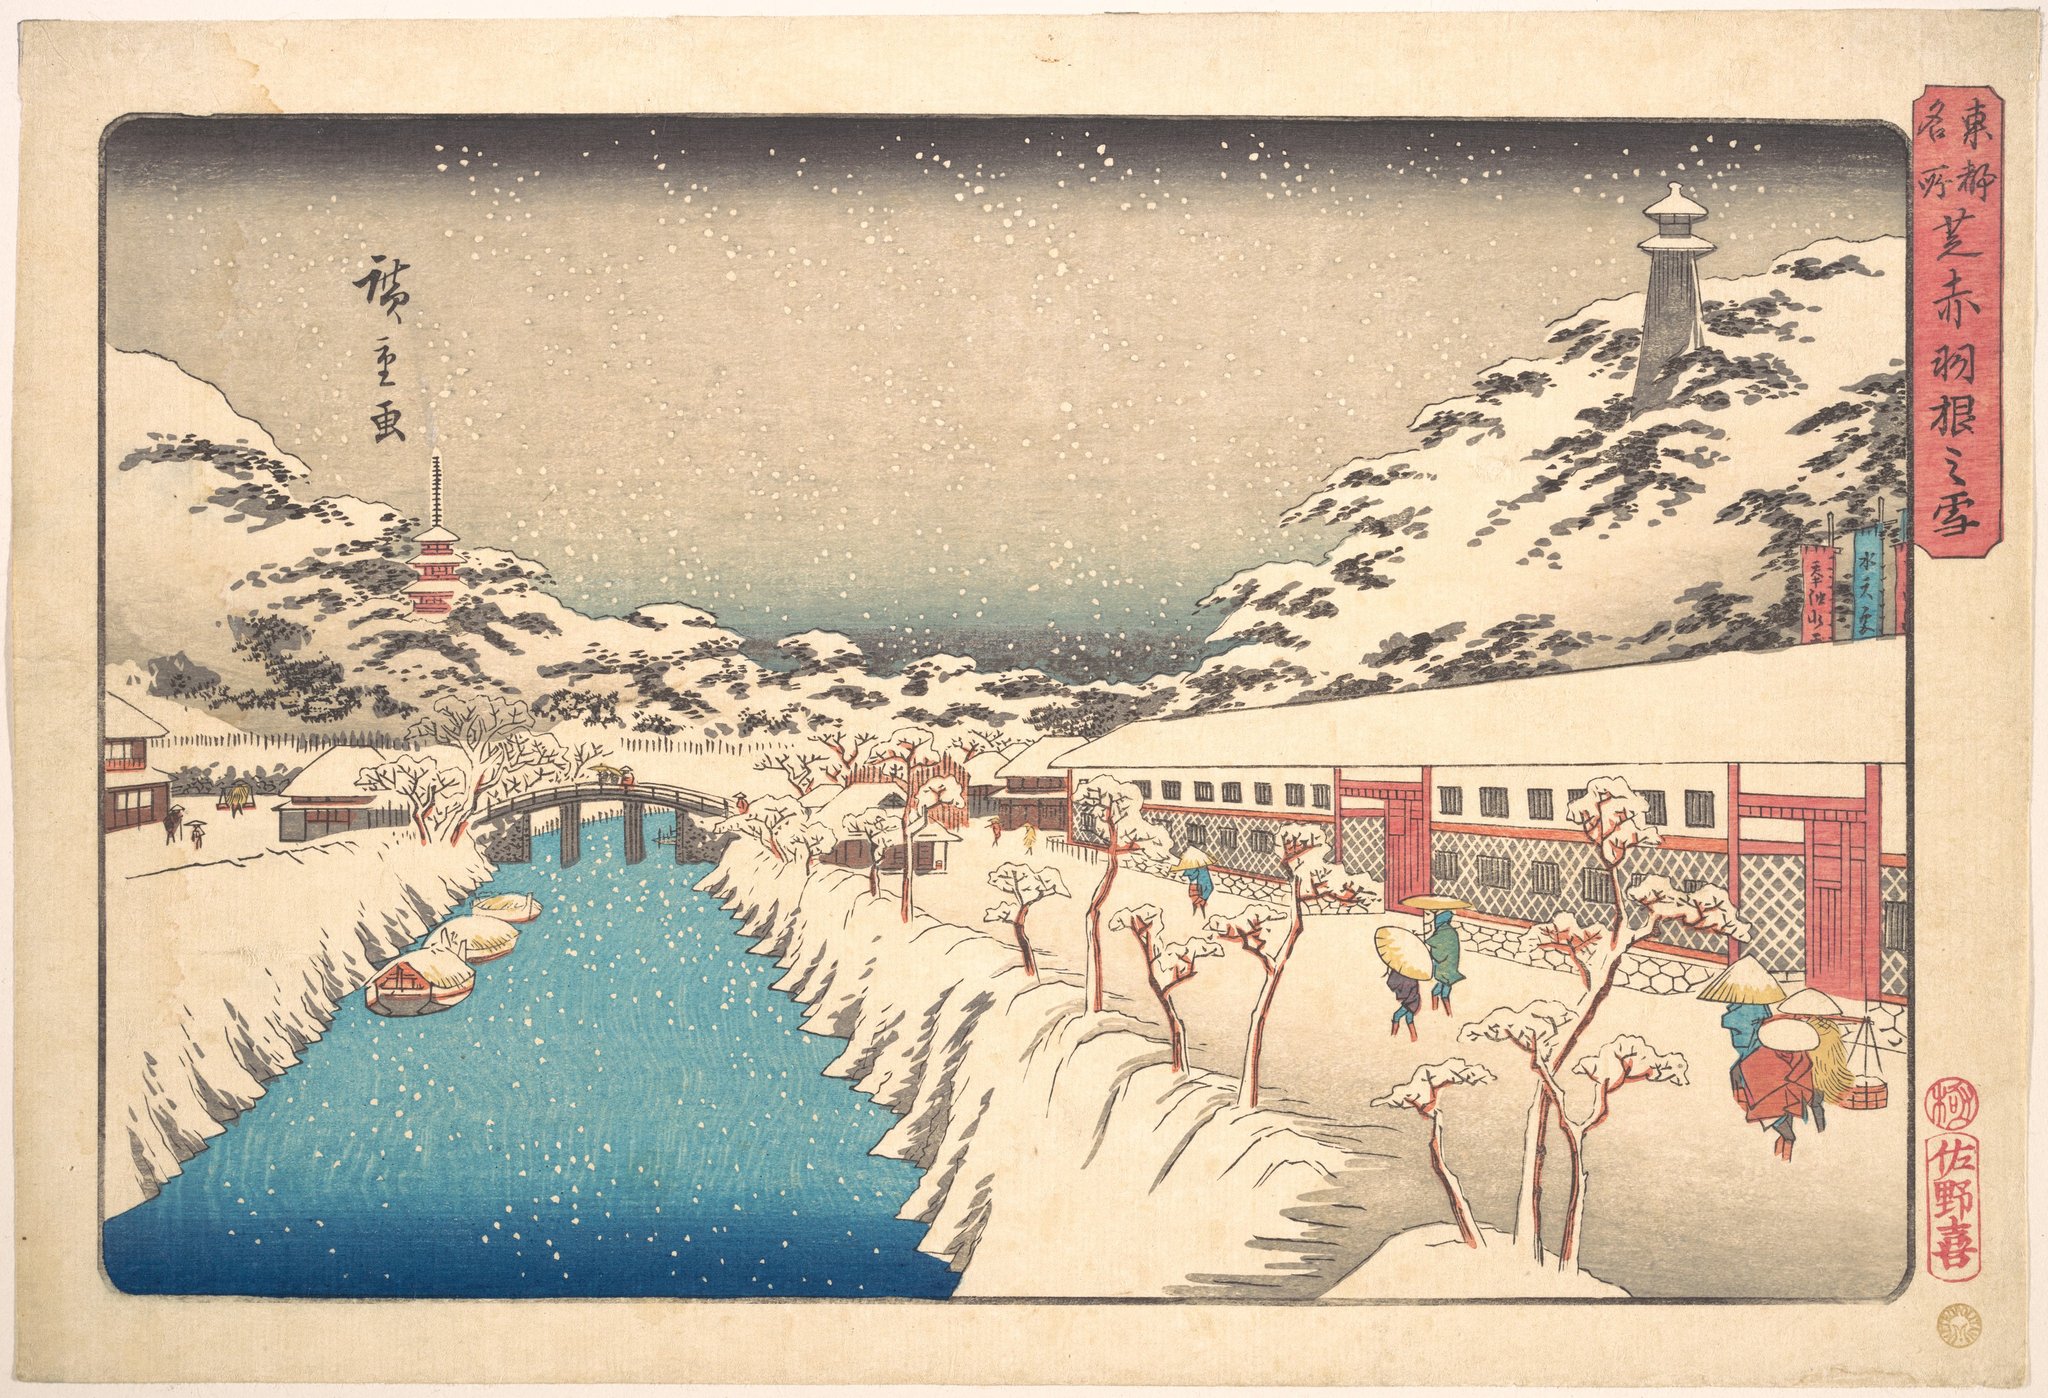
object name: print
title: Shiba, Akabane no Yuki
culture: japanese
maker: utagawa hiroshige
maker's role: artist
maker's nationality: japanese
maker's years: 1797-1858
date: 1837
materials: ink, paper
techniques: woodblock print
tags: bridges,rivers,snow